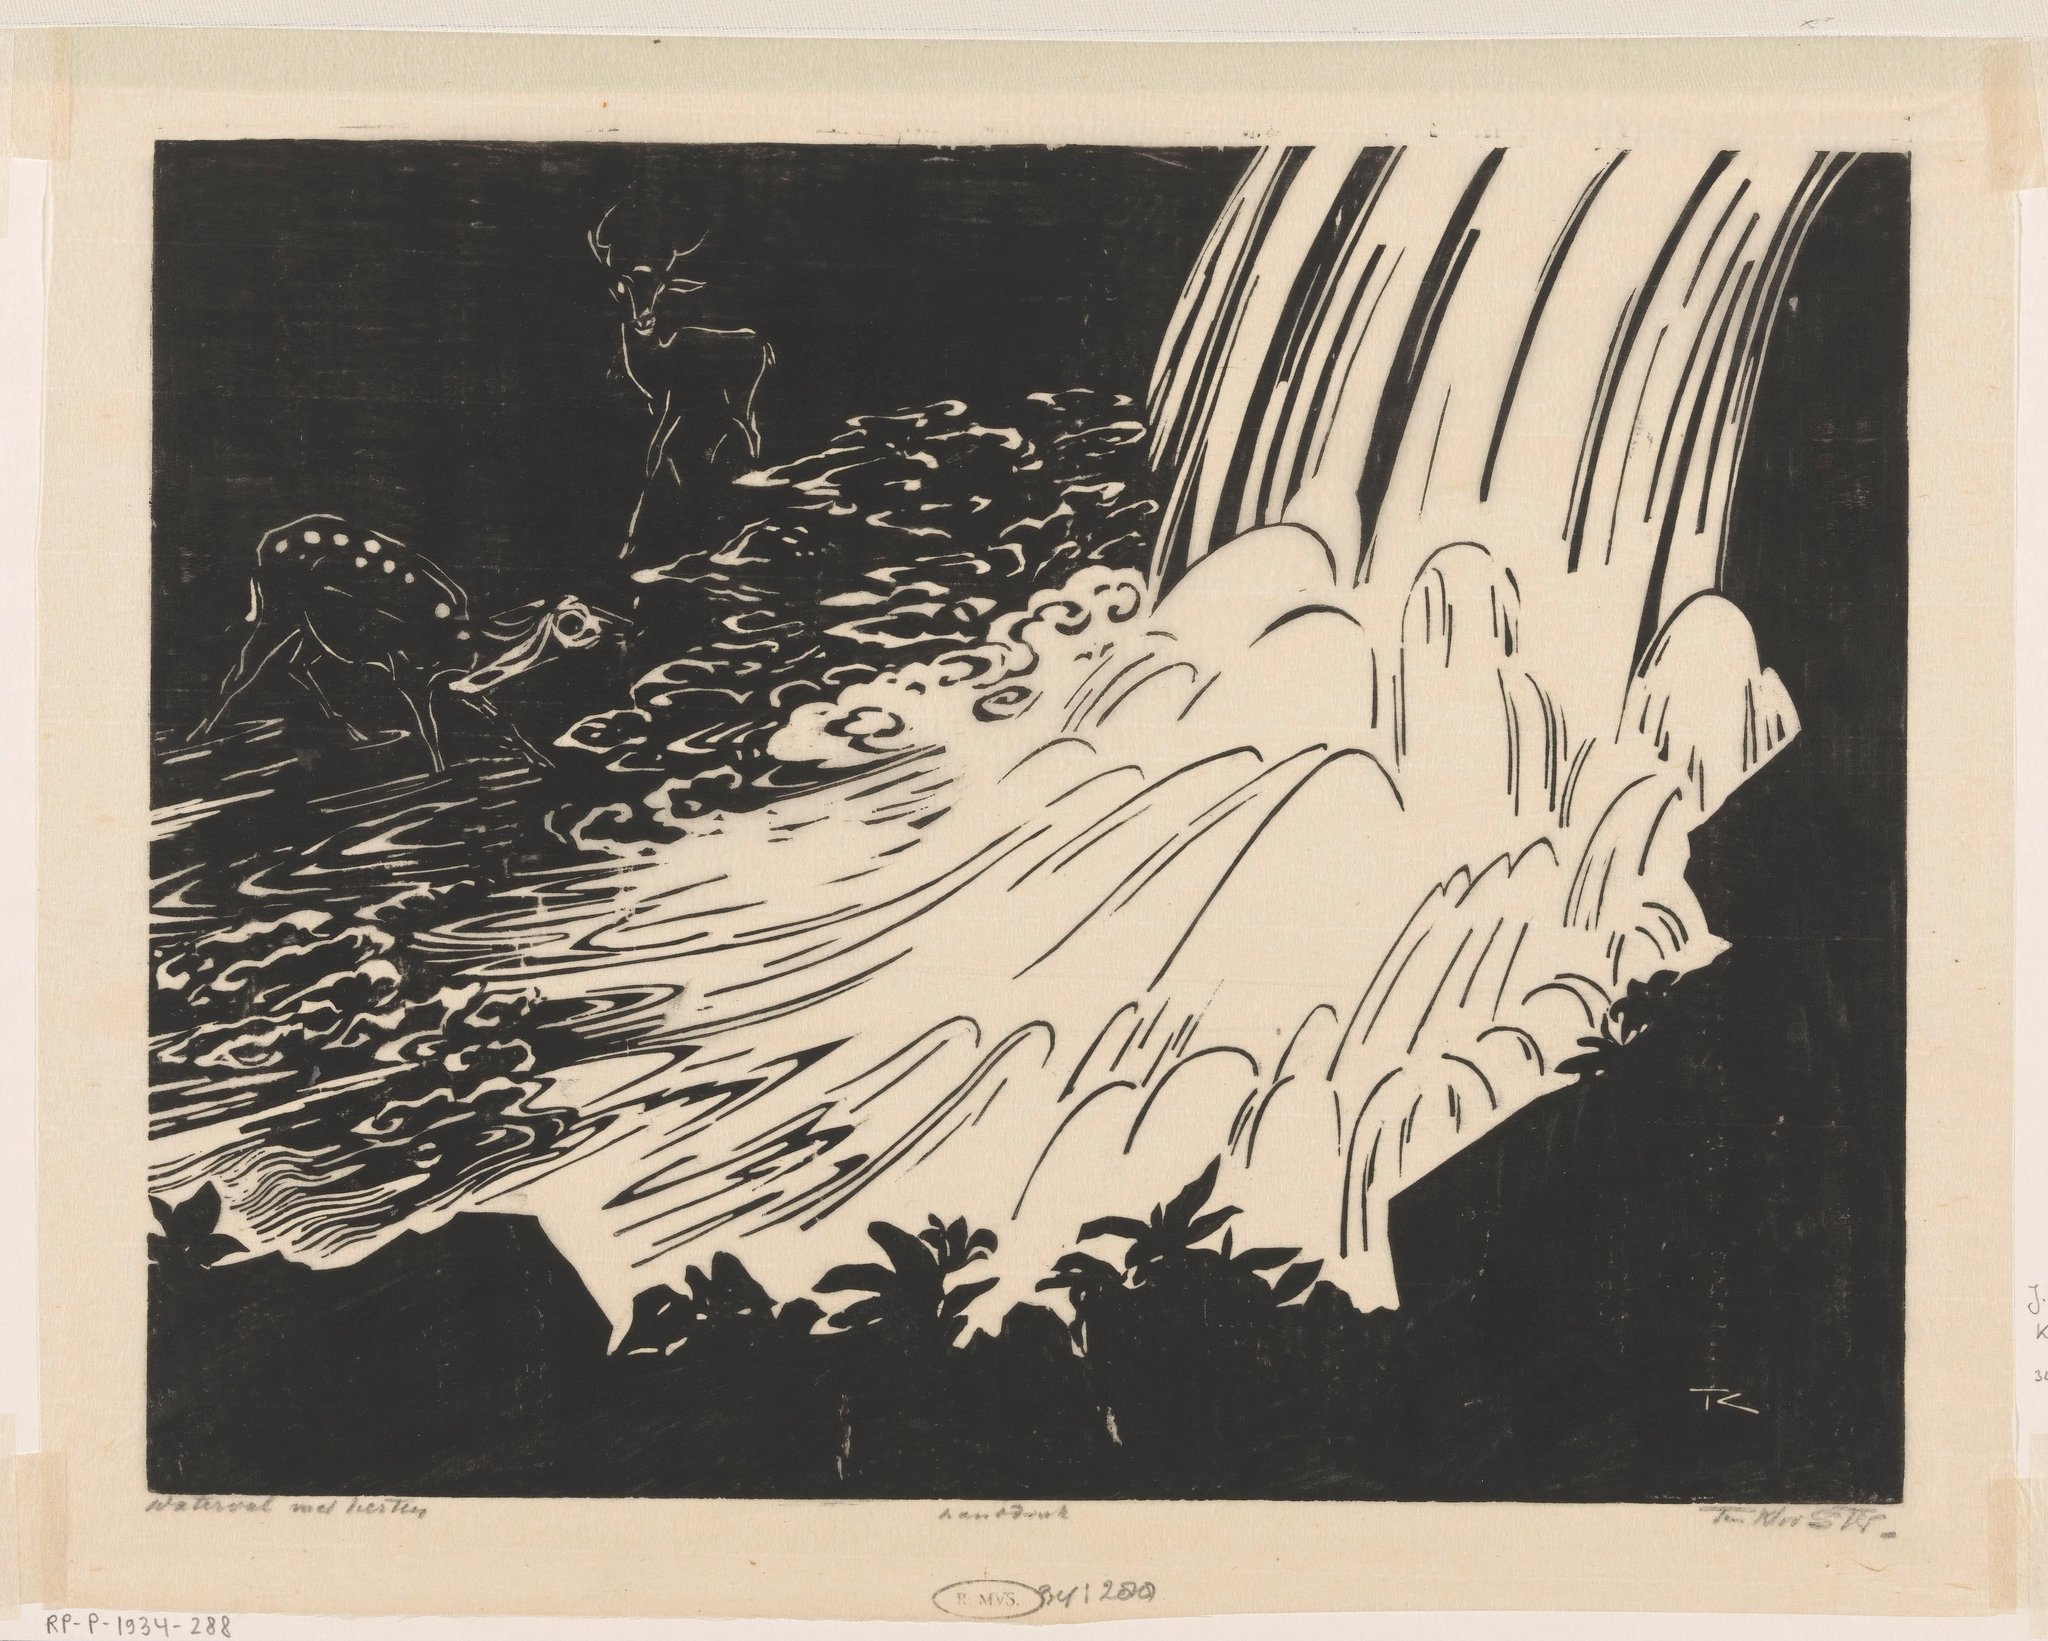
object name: print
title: Waterval met herten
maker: johannes frederik engelbert ten klooster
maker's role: draughtsman, print maker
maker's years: 1873-1940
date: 1925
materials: paper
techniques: woodcut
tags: hoofed animals: deer, waterfall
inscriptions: collector's mark: Lugt 2228